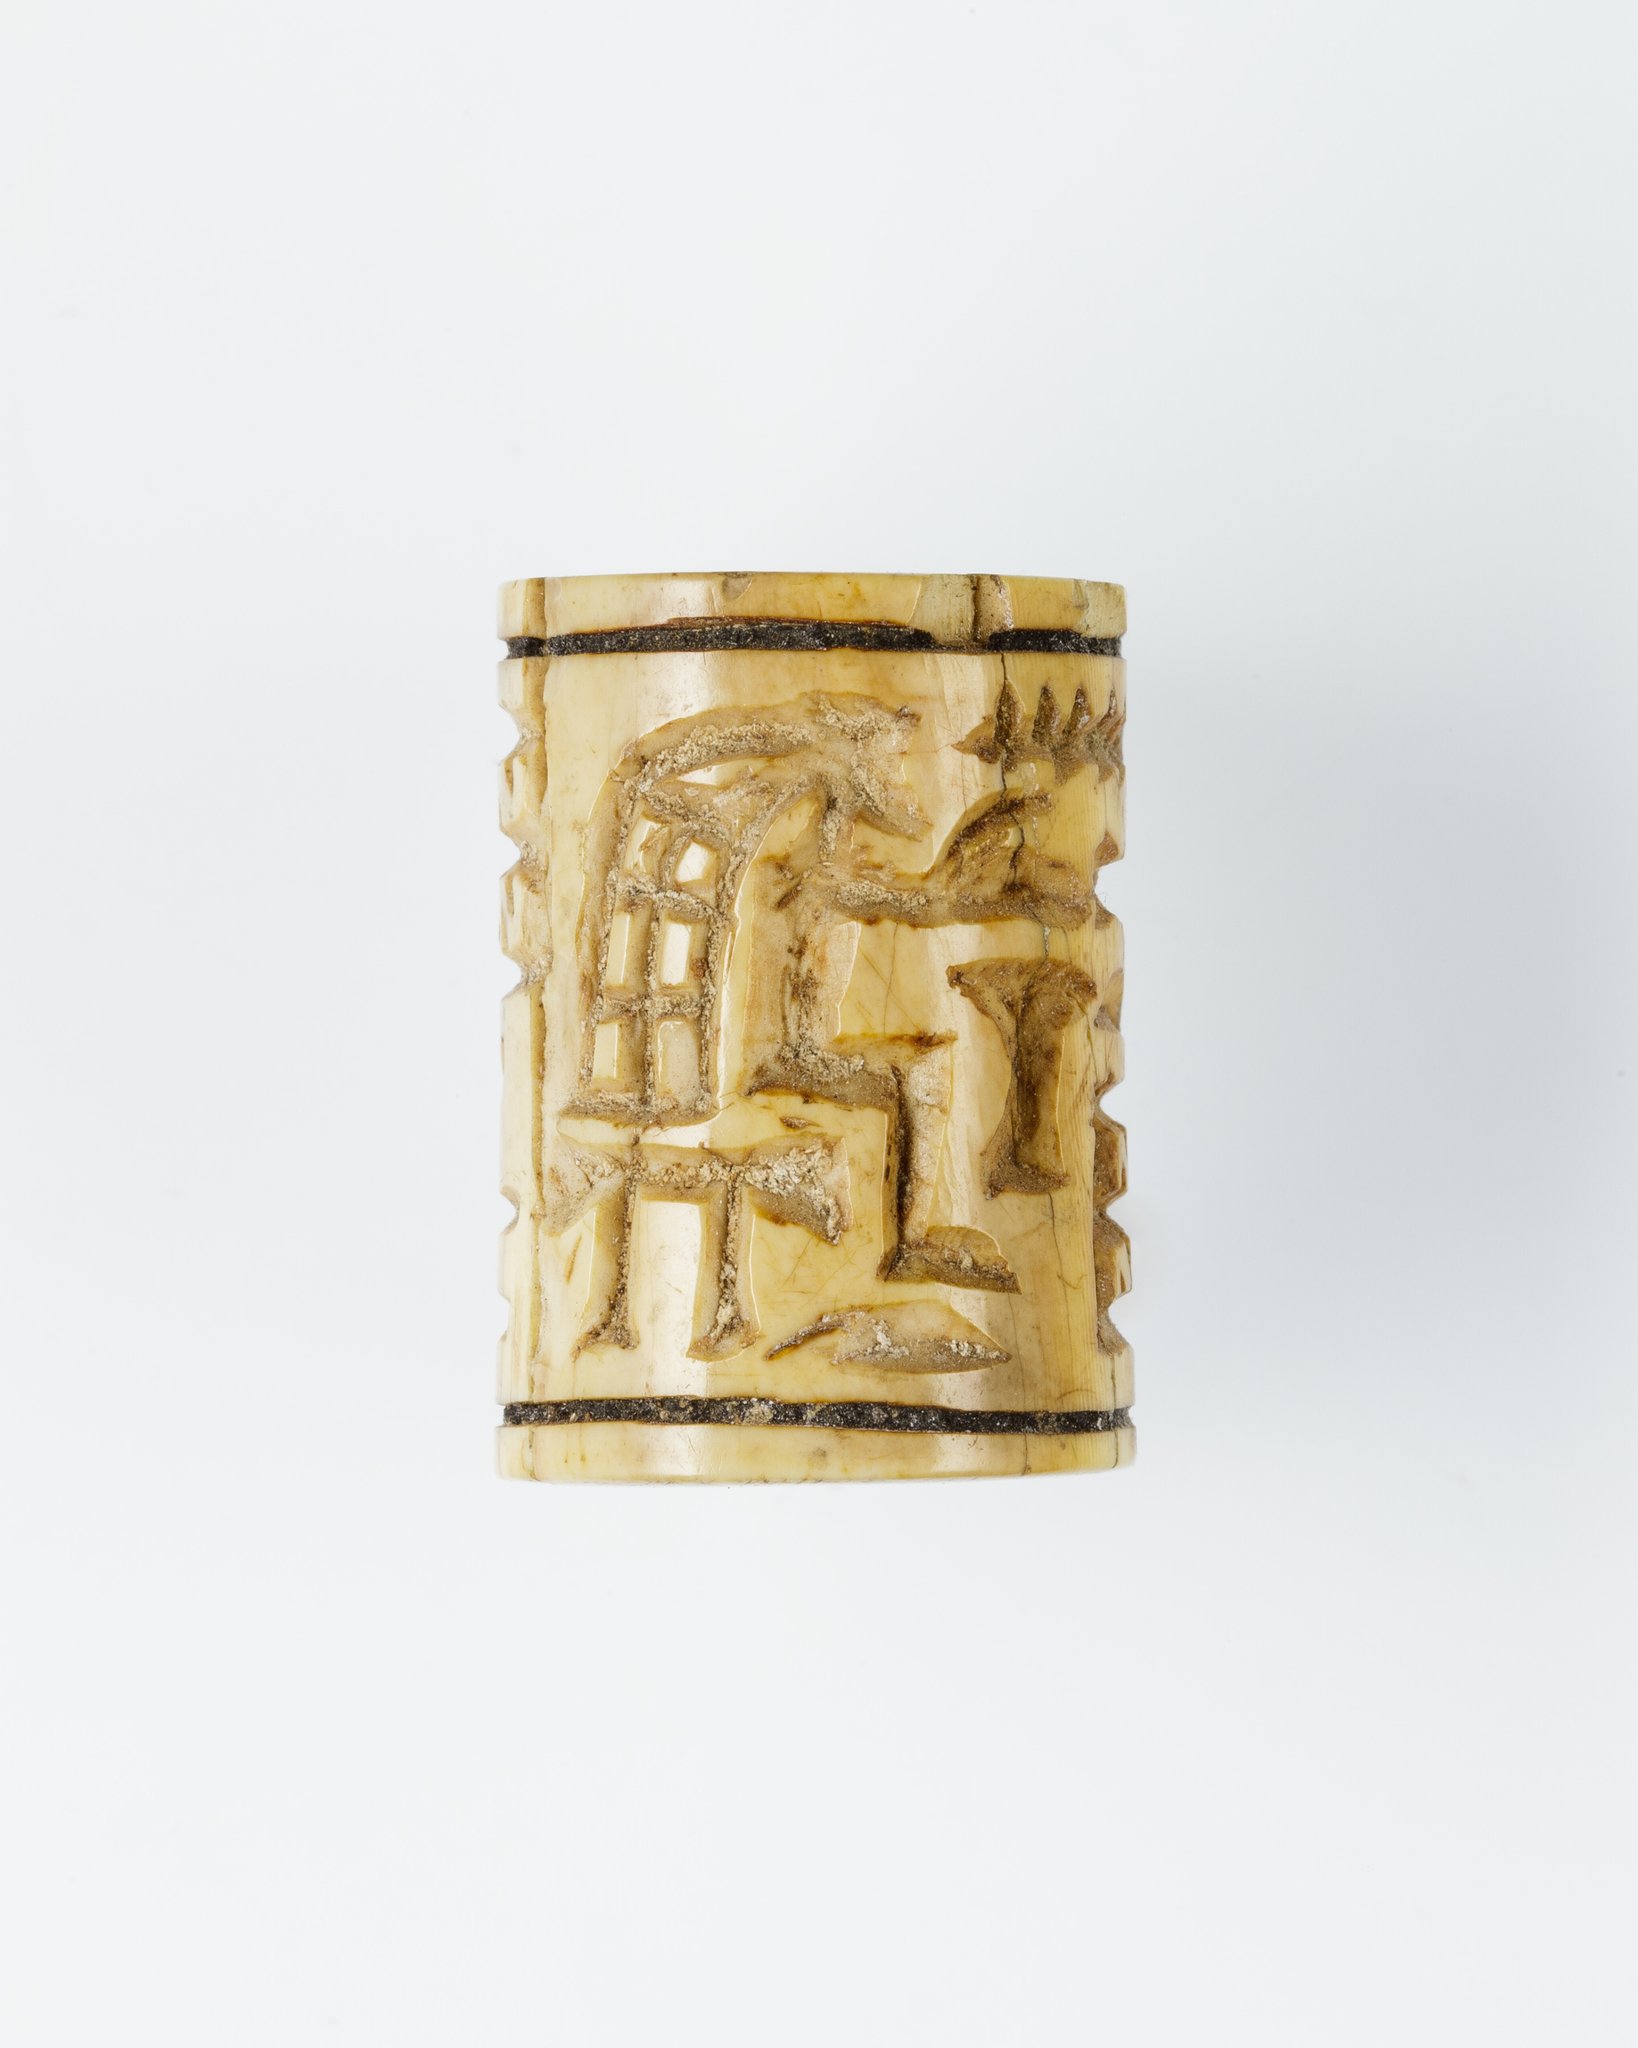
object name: cylinder seal, personal name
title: Cylinder seal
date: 2960-2770 BCE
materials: ivory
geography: egypt